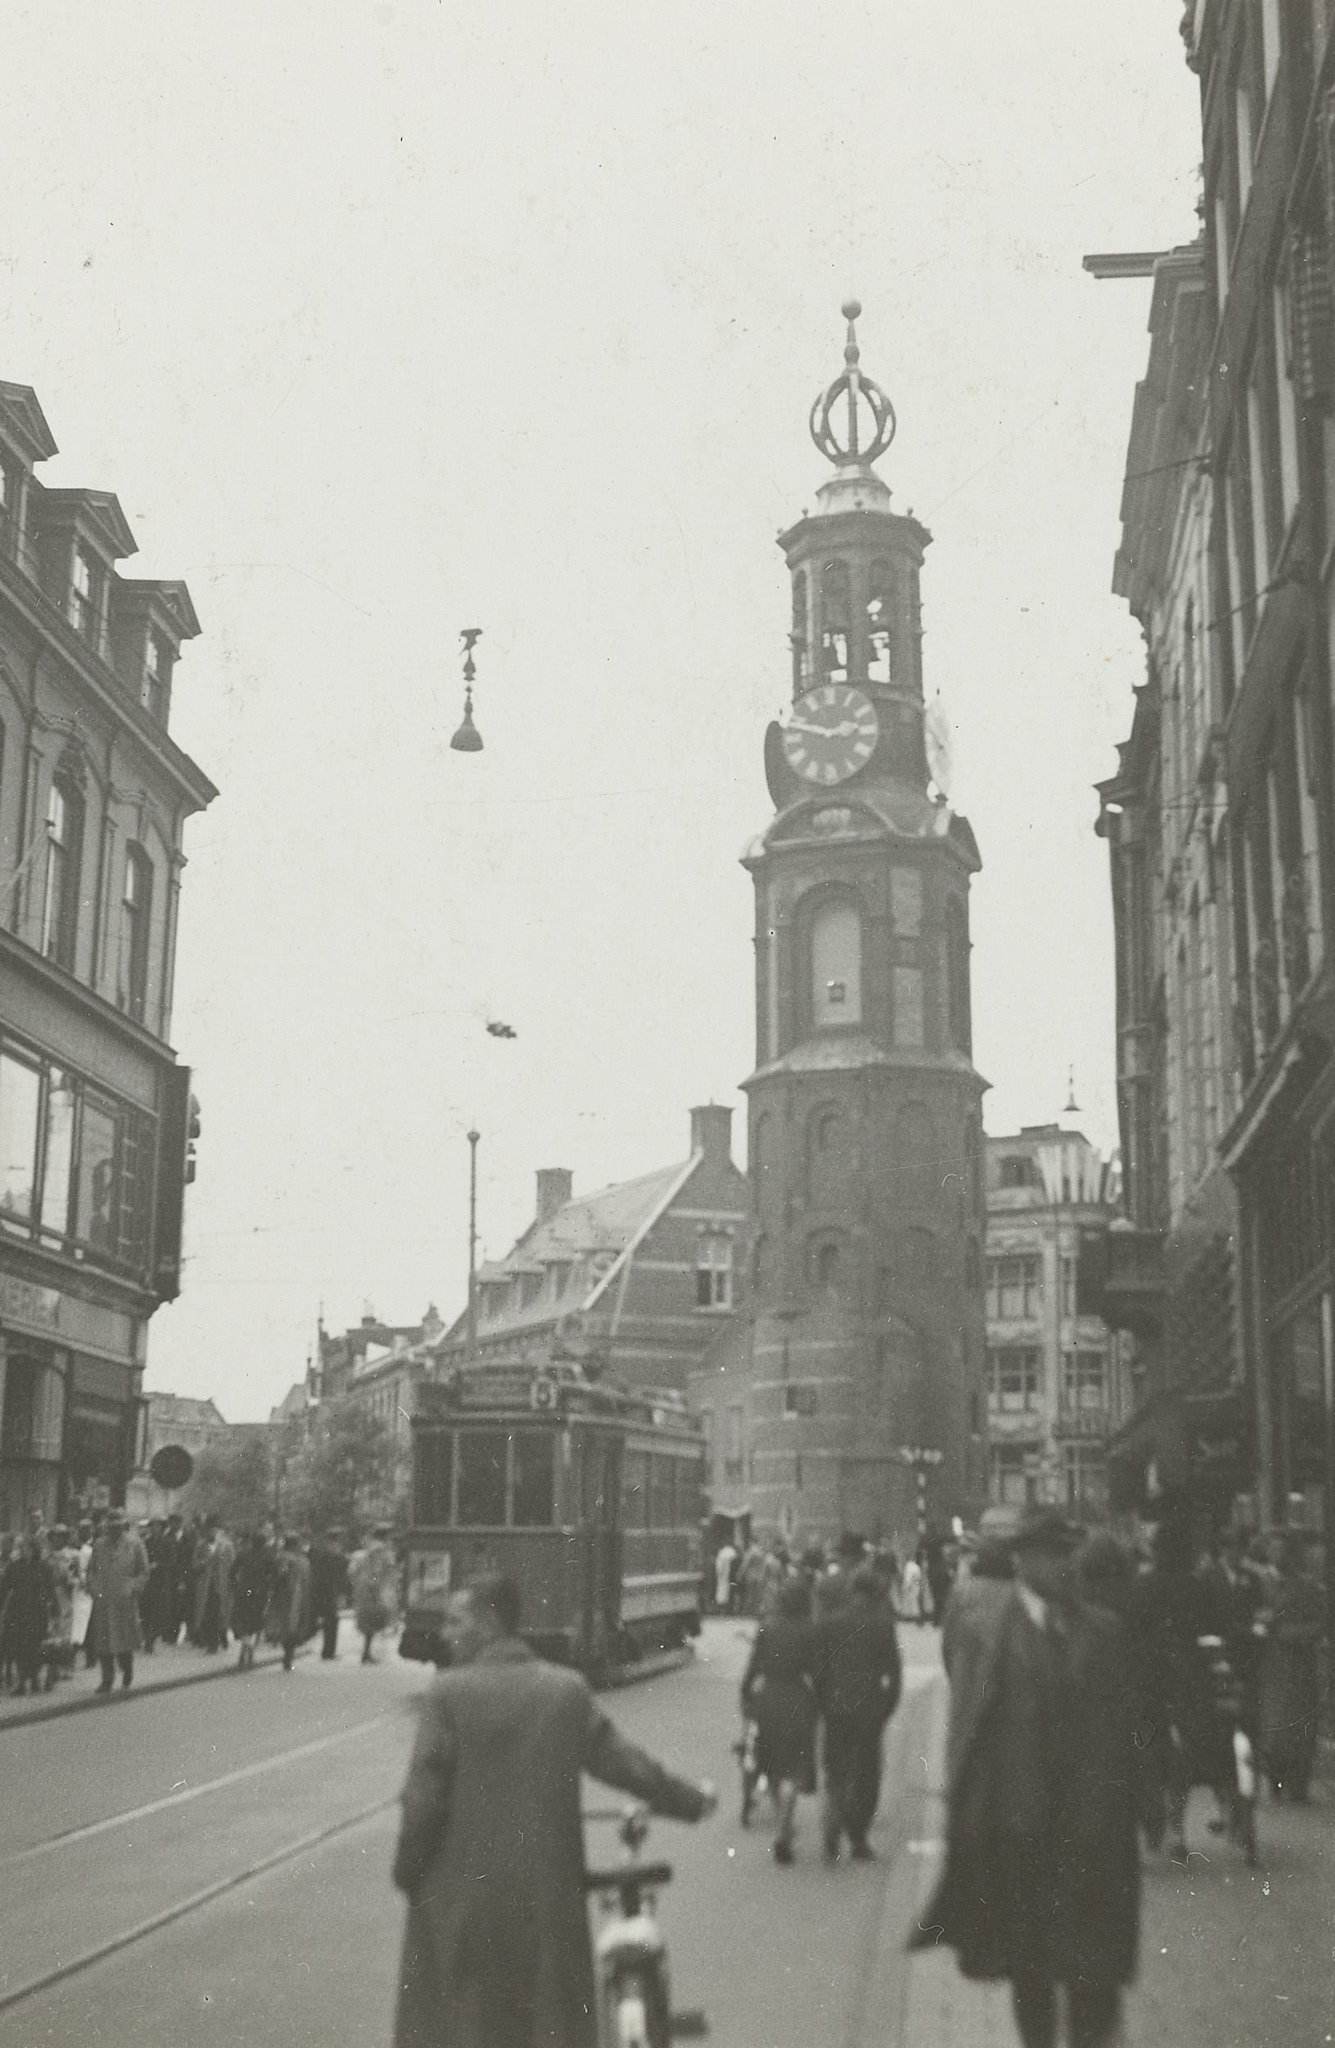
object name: photograph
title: De Munttoren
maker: Anonymous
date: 1941-1942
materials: photographic support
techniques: gelatin silver print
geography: amsterdam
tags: city-view in general; 'veduta', occupation ~ war, netherlands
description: De Munttoren in Amsterdam gezien vanuit de Reguliersbreestraat. In de straat rijdt een tram, lijn 5. Achterop staat: Amsterdam, Rembrandtstr.